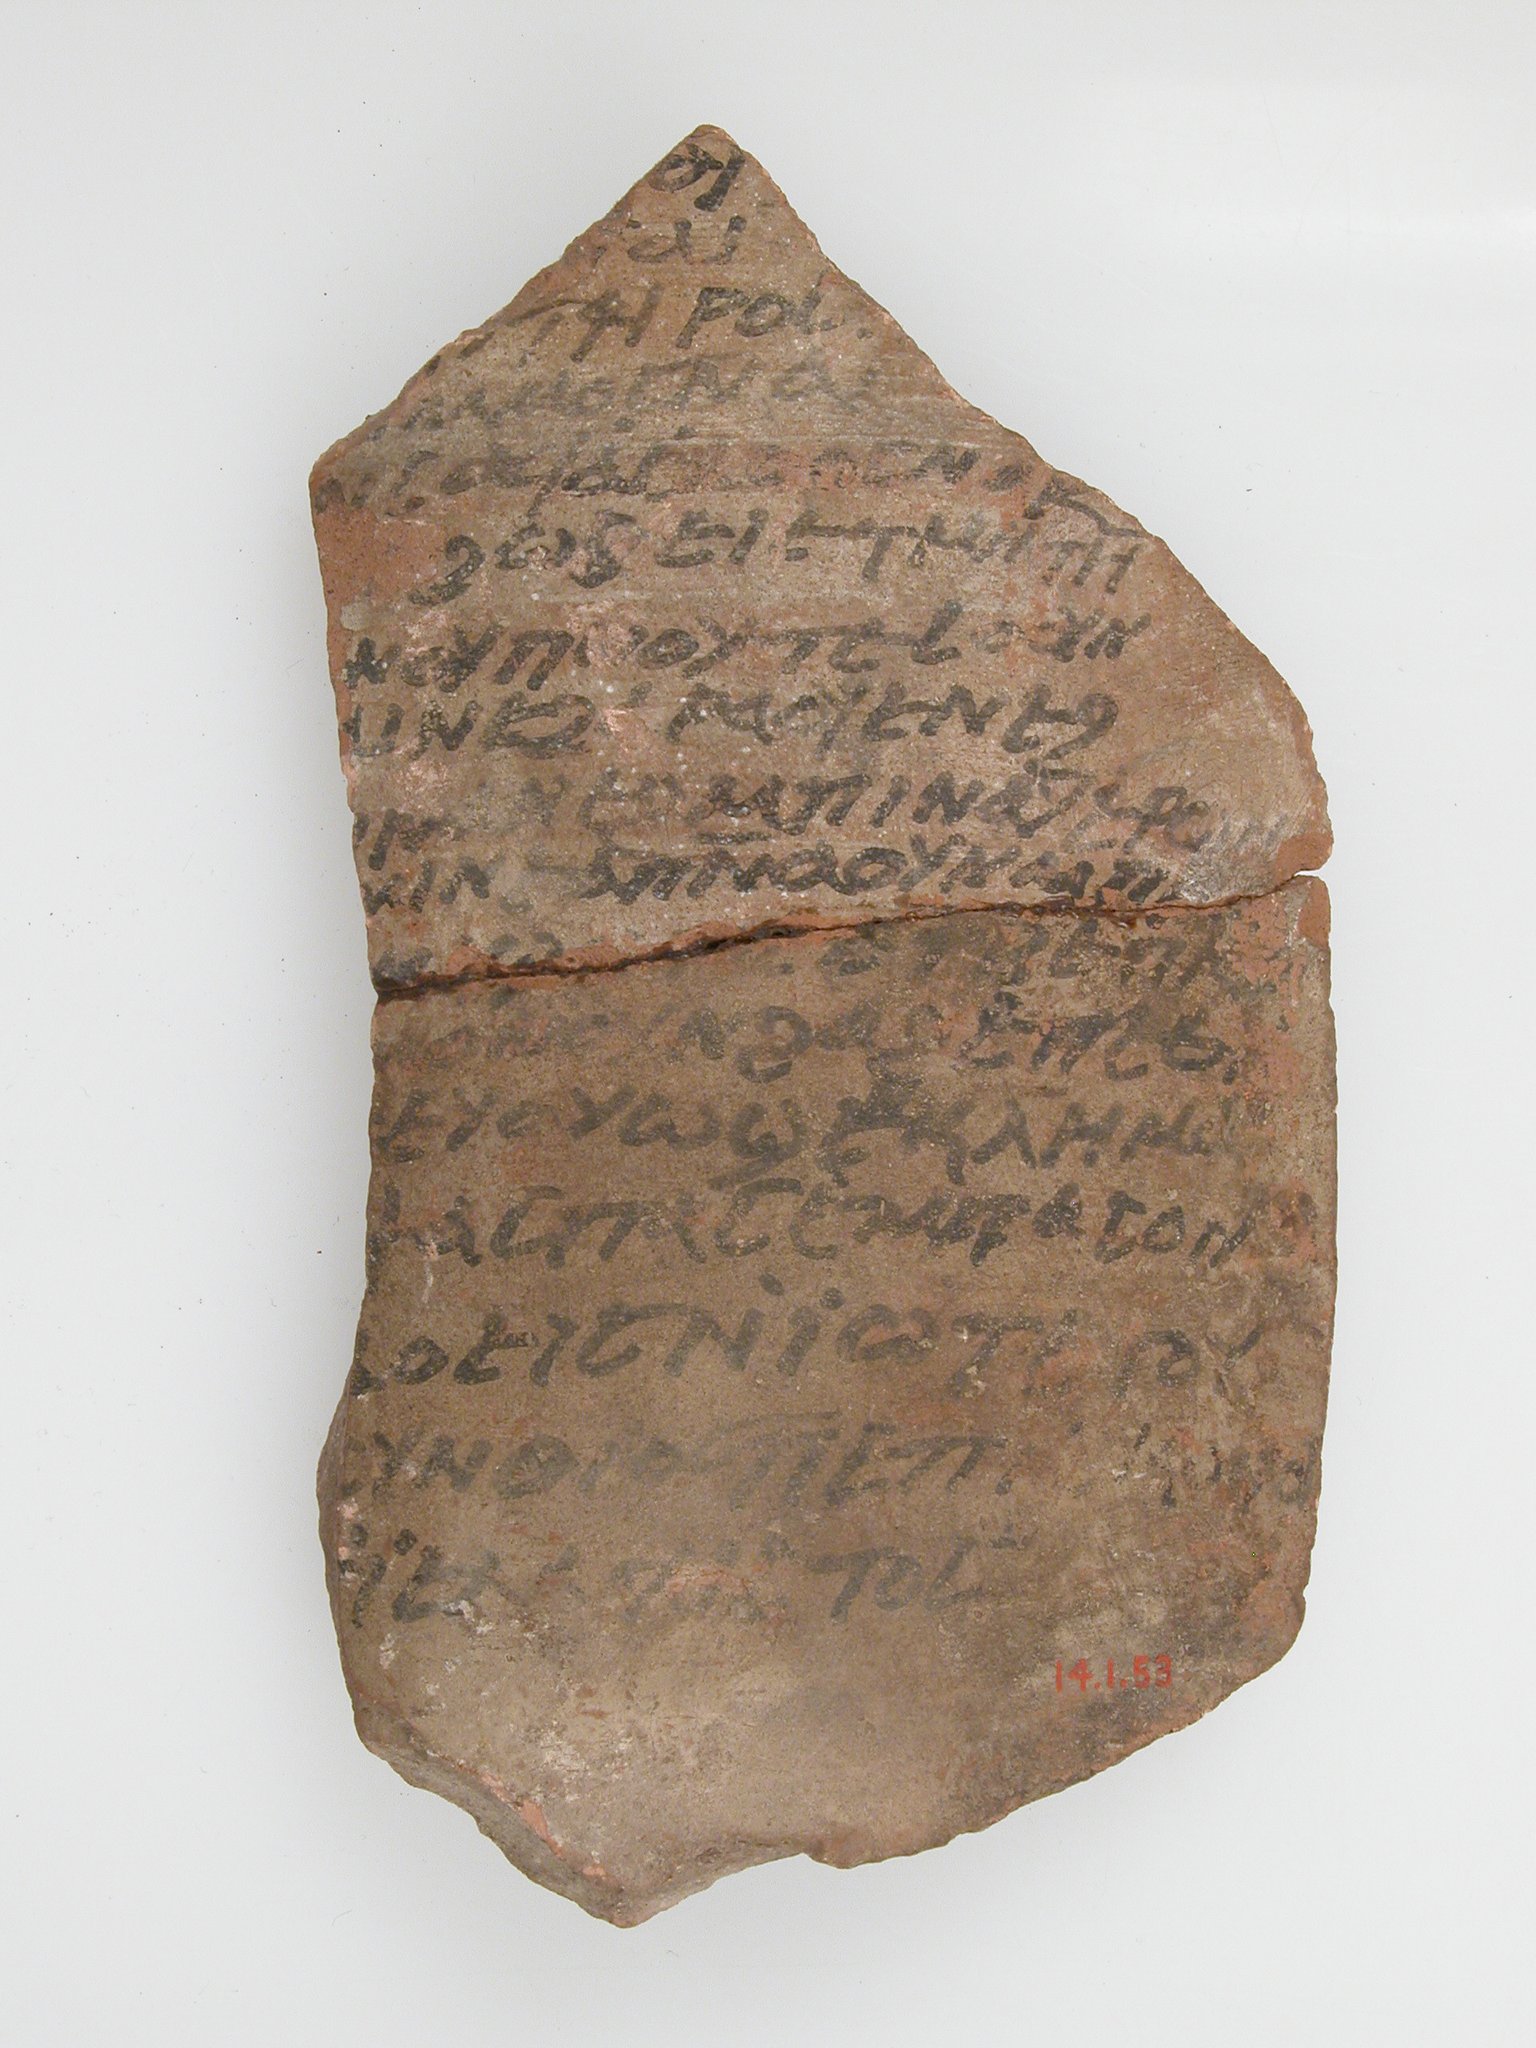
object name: ostrakon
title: Ostrakon with a Letter to Bishop Pesenthius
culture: coptic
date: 600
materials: ink, pottery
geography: egypt